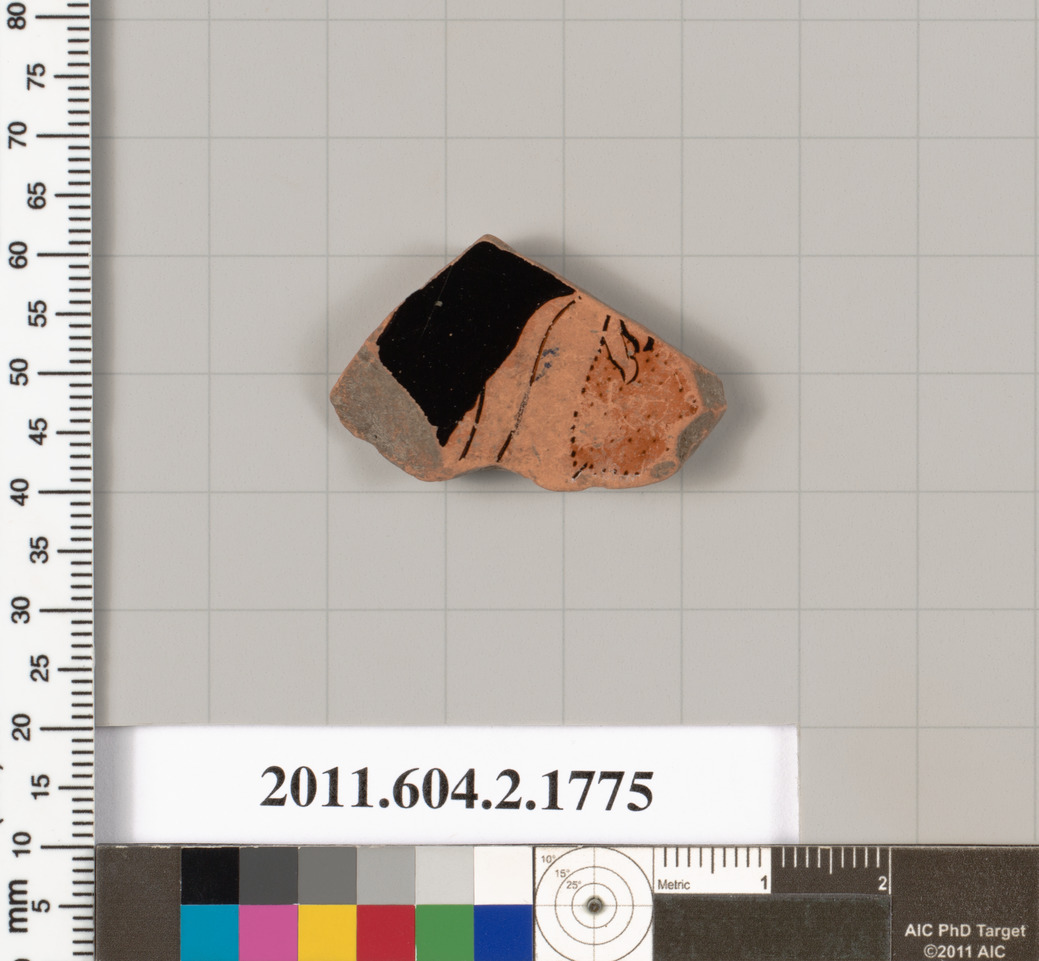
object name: skyphos fragment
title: Terracotta fragment of a skyphos (deep drinking cup)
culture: greek, attic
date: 490-470 BCE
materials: terracotta